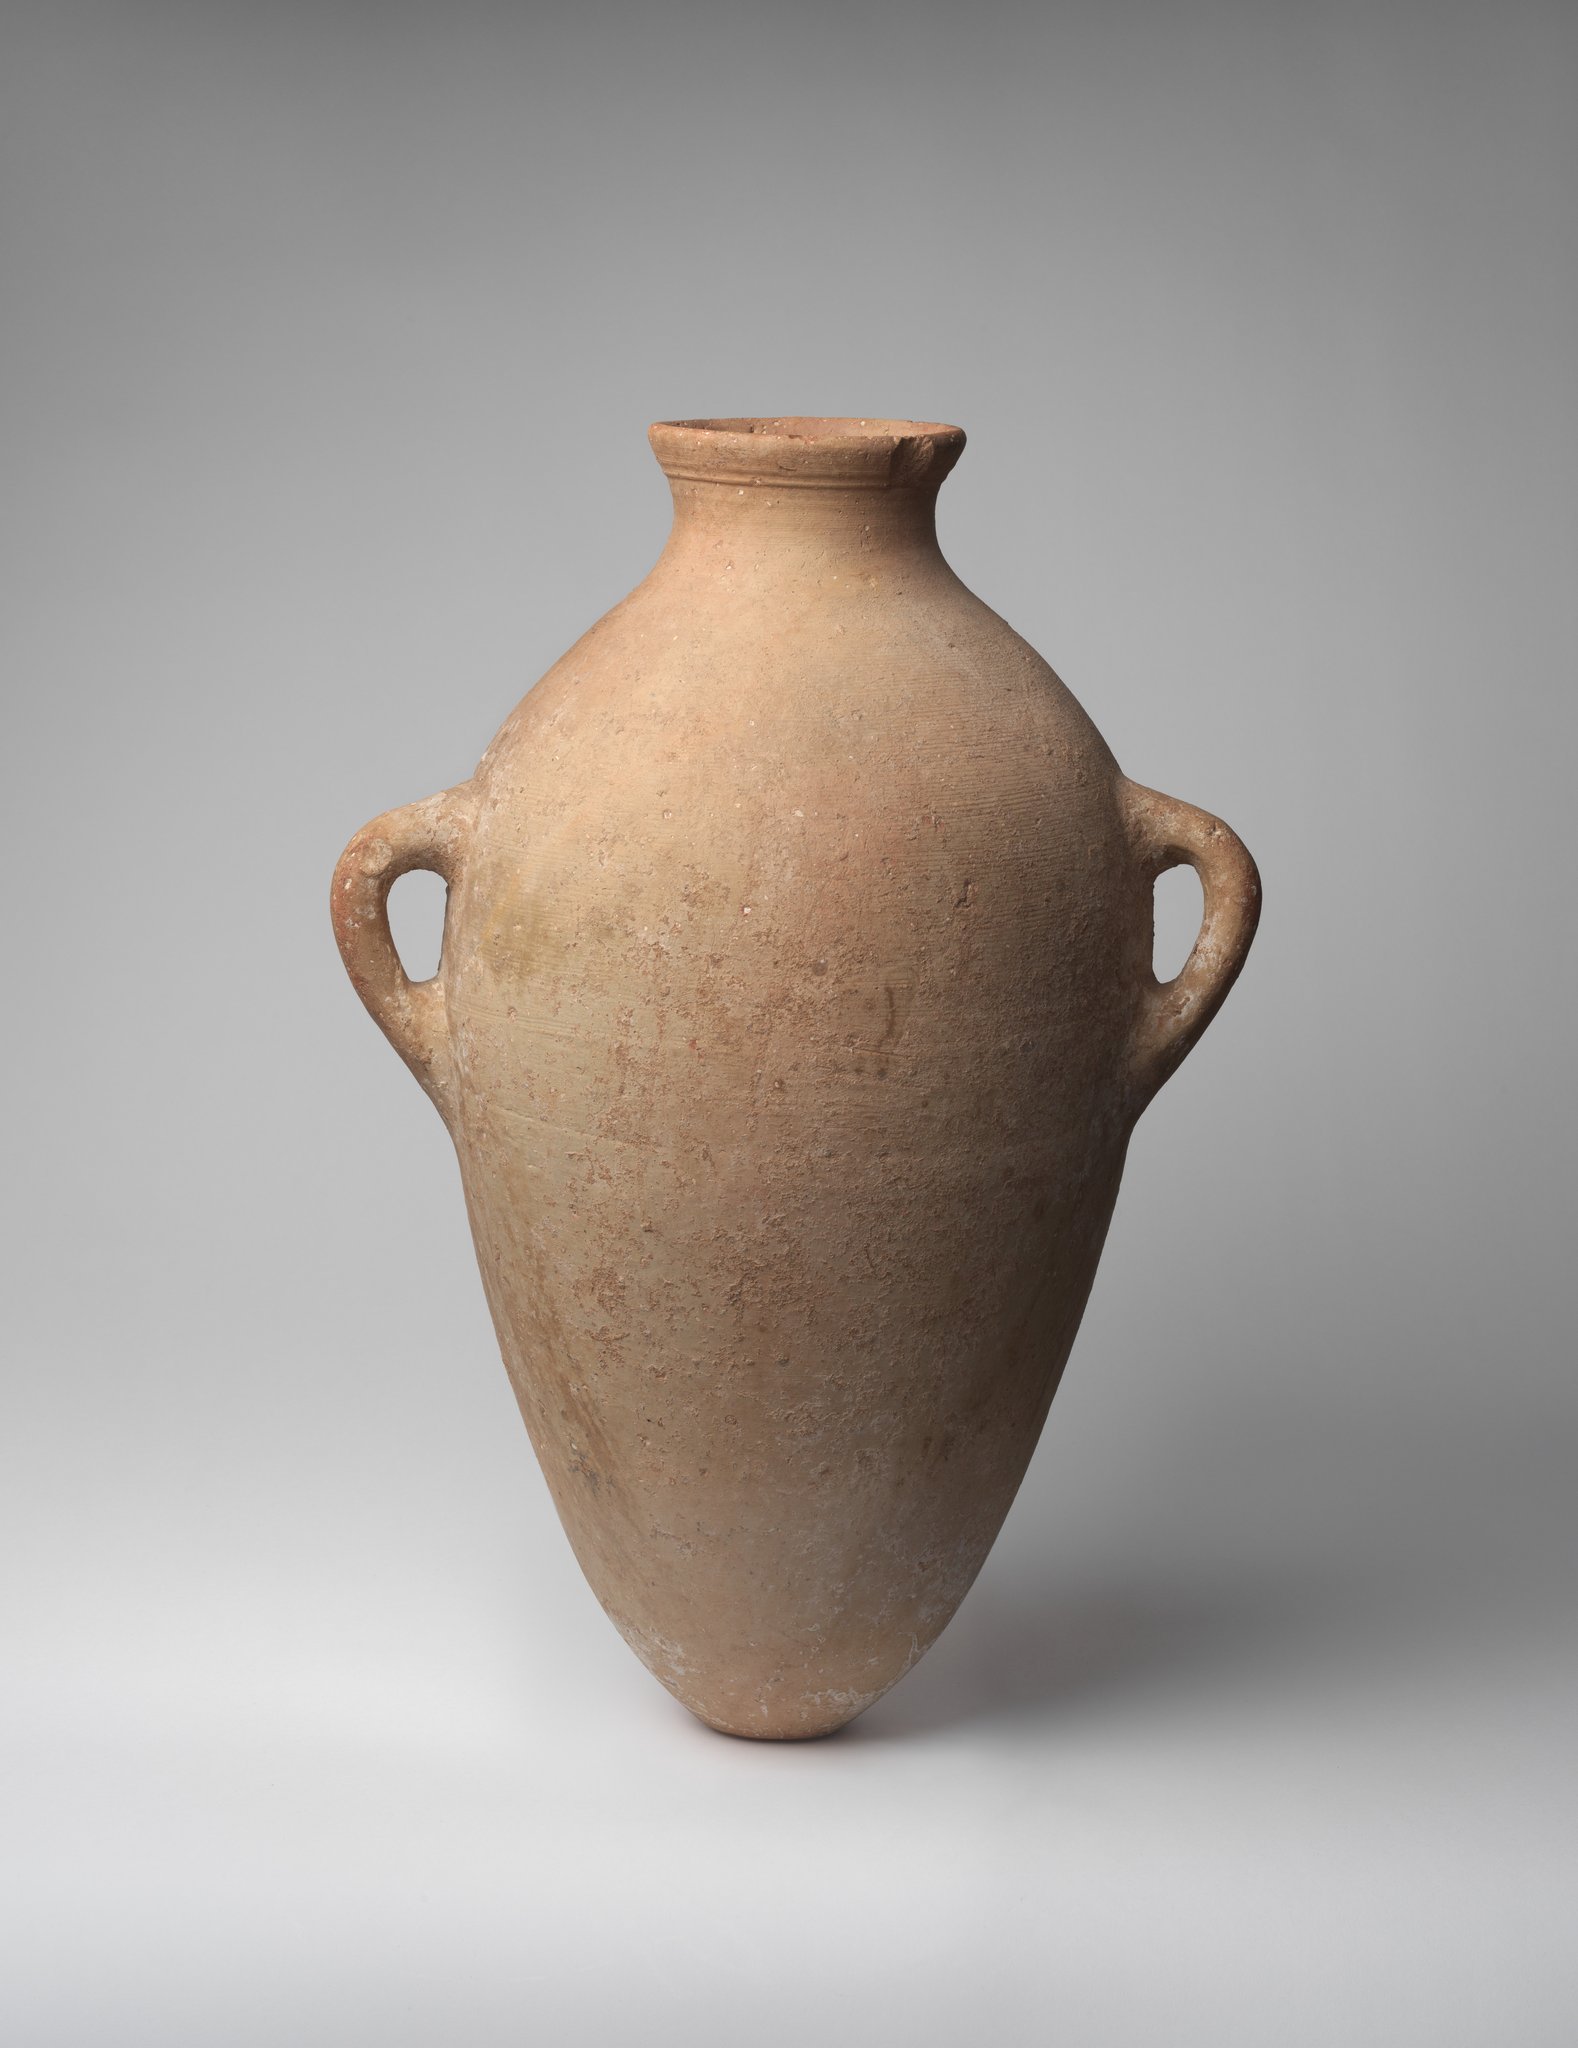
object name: jar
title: Canaanite jar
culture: canaanite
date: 1500-1400 BCE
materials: ceramic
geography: levant